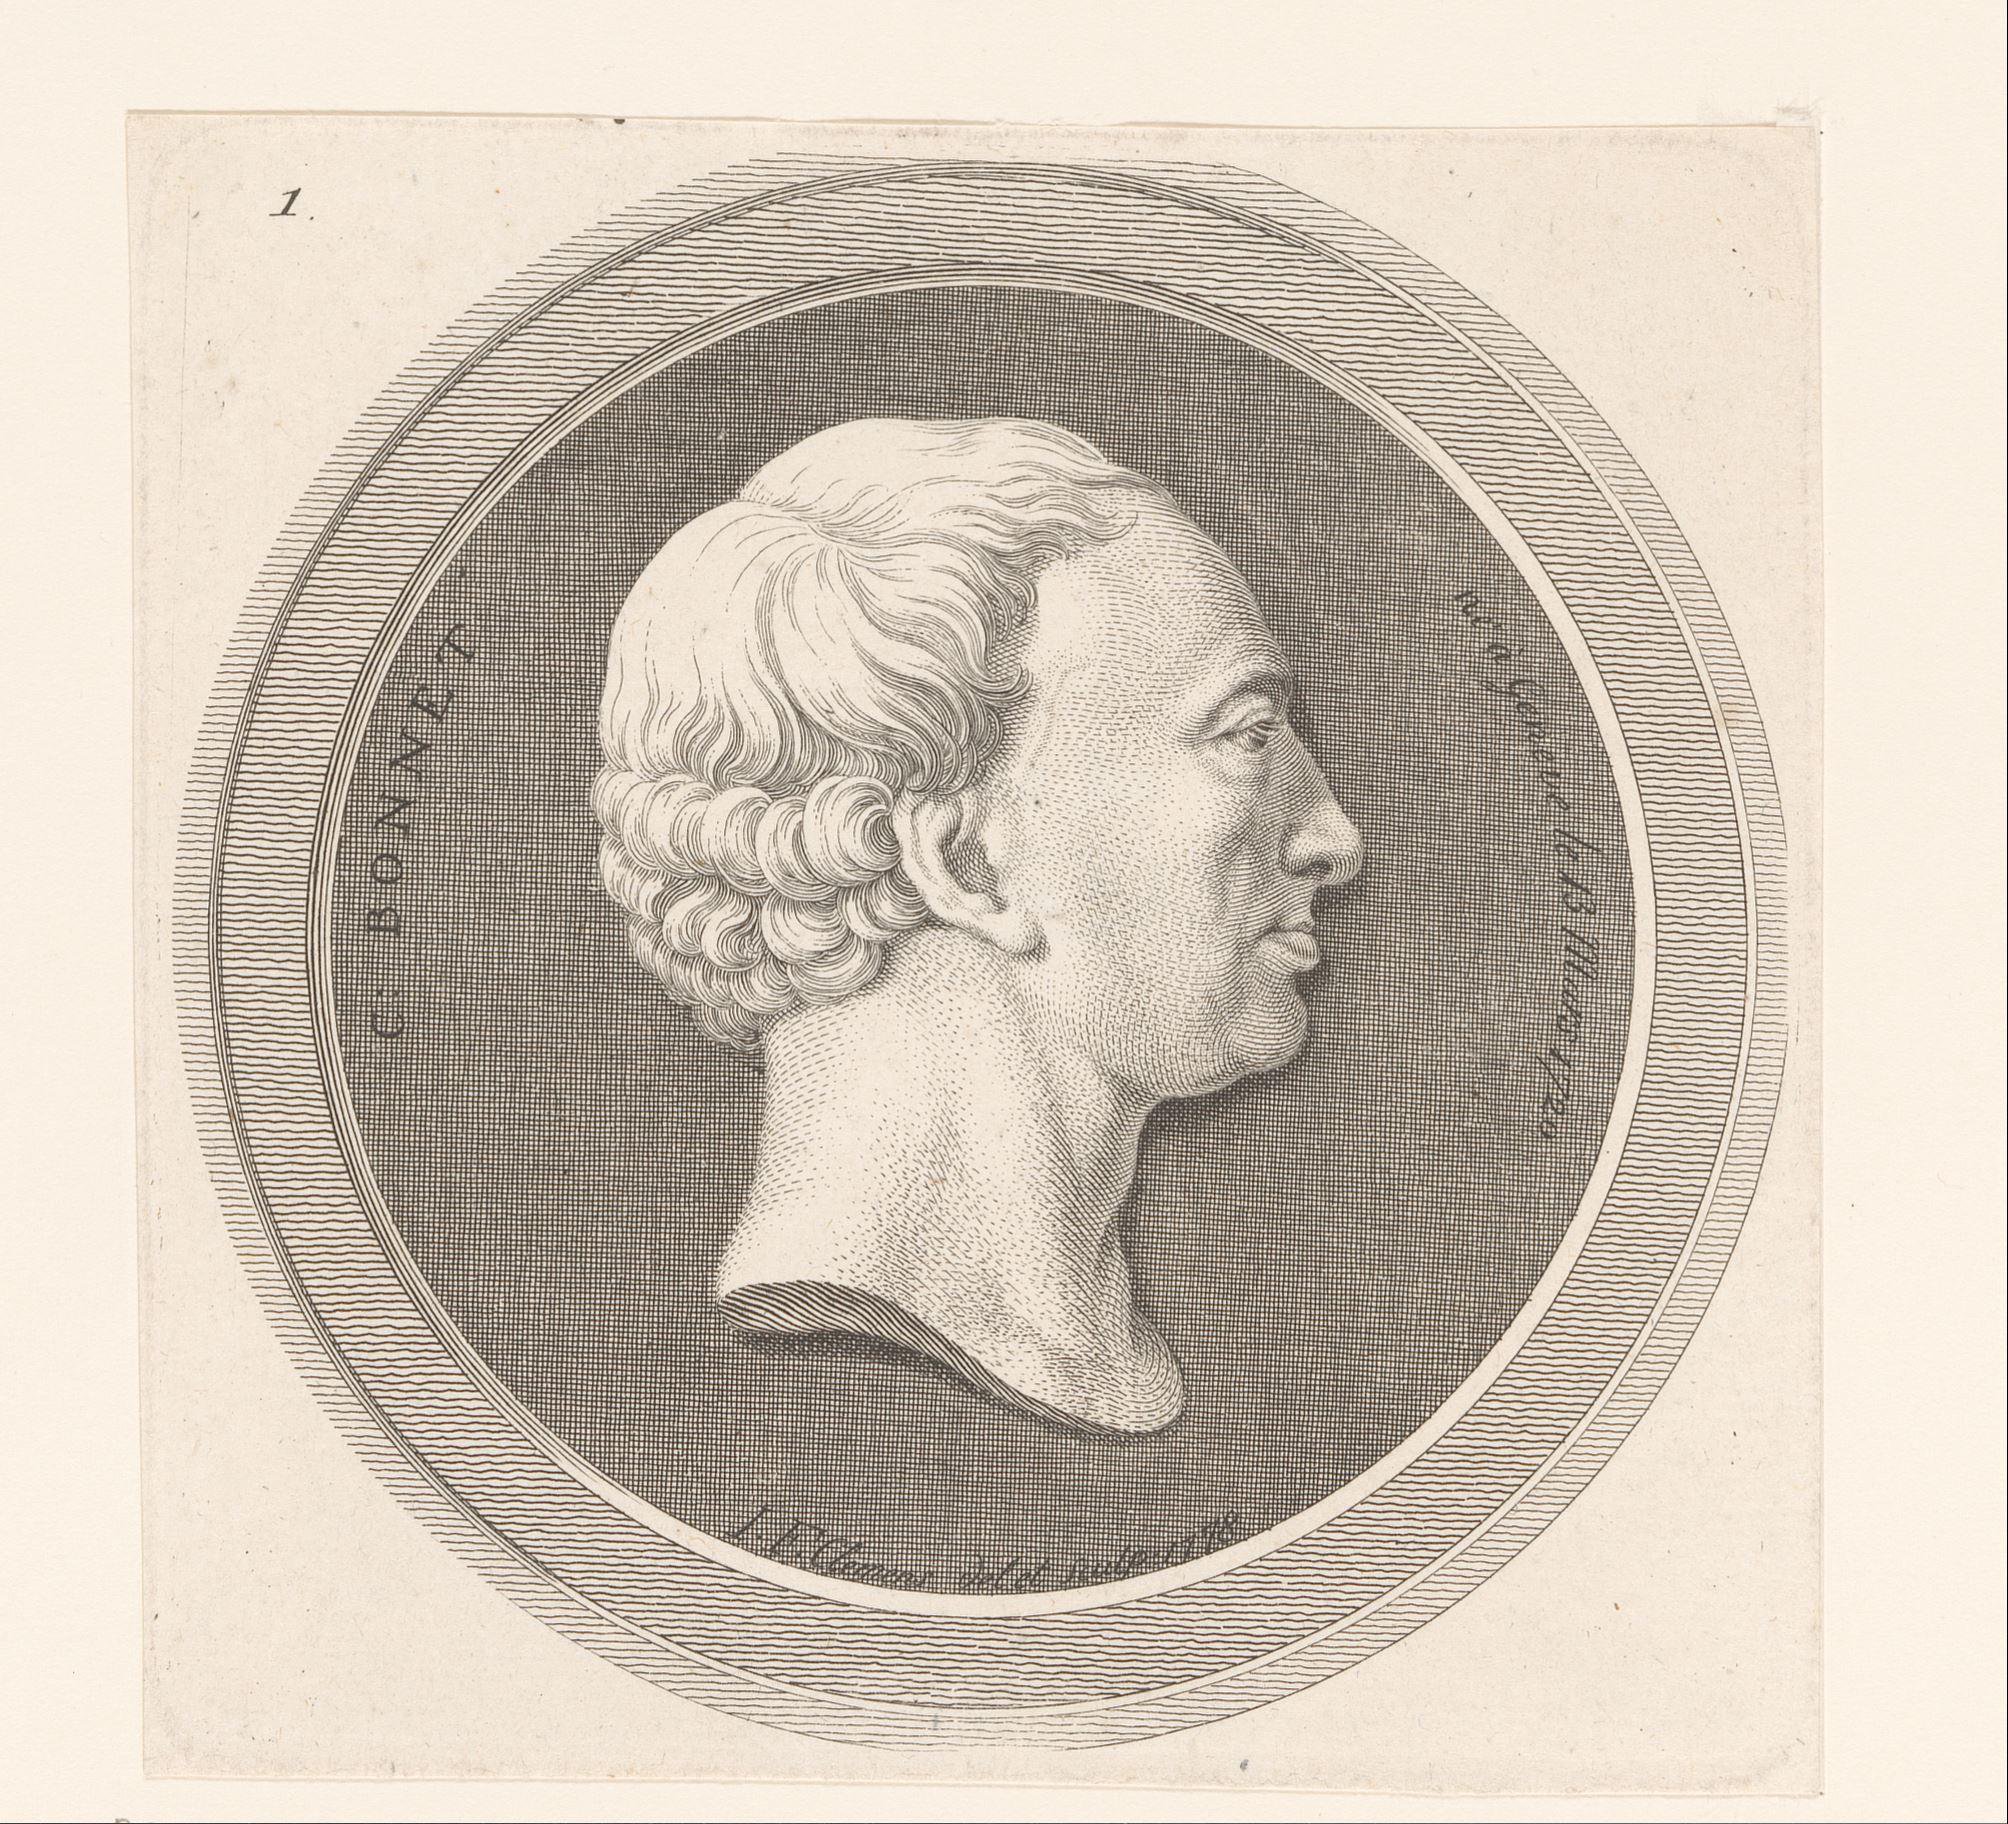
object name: print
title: Portret van Charles Bonnet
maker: johan frederik clemens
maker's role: draughtsman, print maker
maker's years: 1748-1831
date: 1778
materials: paper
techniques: engraving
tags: historical persons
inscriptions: collector's mark: Lugt 2228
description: Portret van de wetenschapper Charles Bonnet, hoofd in medaillon, en profil naar rechts. Linksboven genummerd: 1.